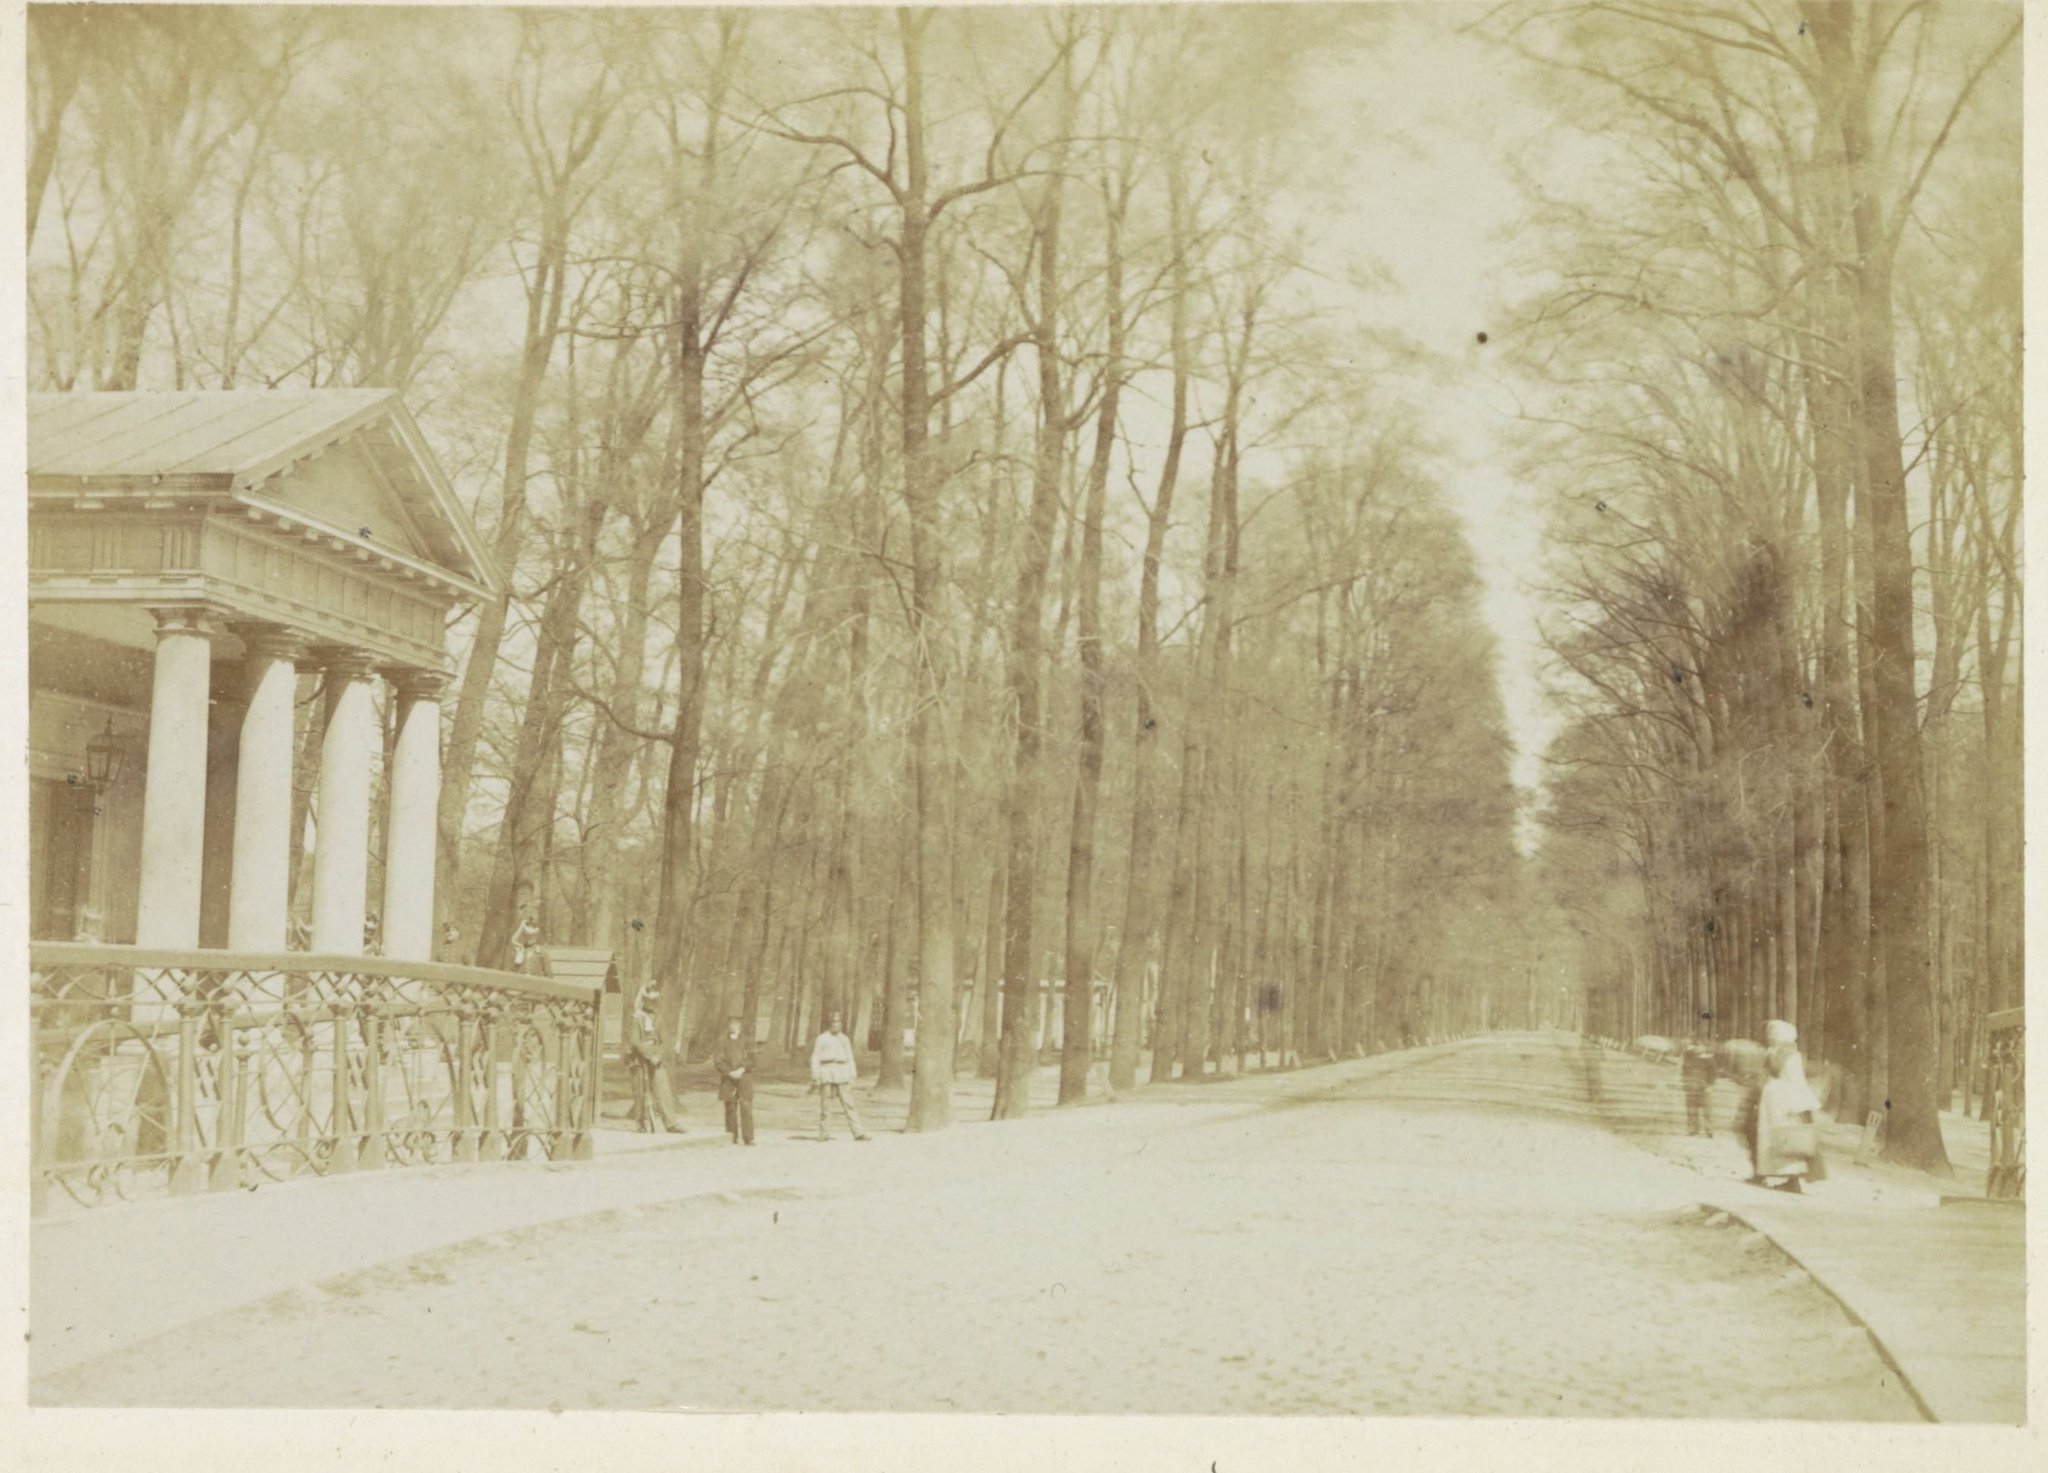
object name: photograph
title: Gezicht op de hoofdingang van het Haagse Bos in Den Haag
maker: andries jager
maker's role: publisher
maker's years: 1825-1905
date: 1865-1870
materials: cardboard, photographic support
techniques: albumen print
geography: the hague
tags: gate, entrance, forest, wood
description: Onderdeel van Leporelloalbum met foto's van Den Haag.